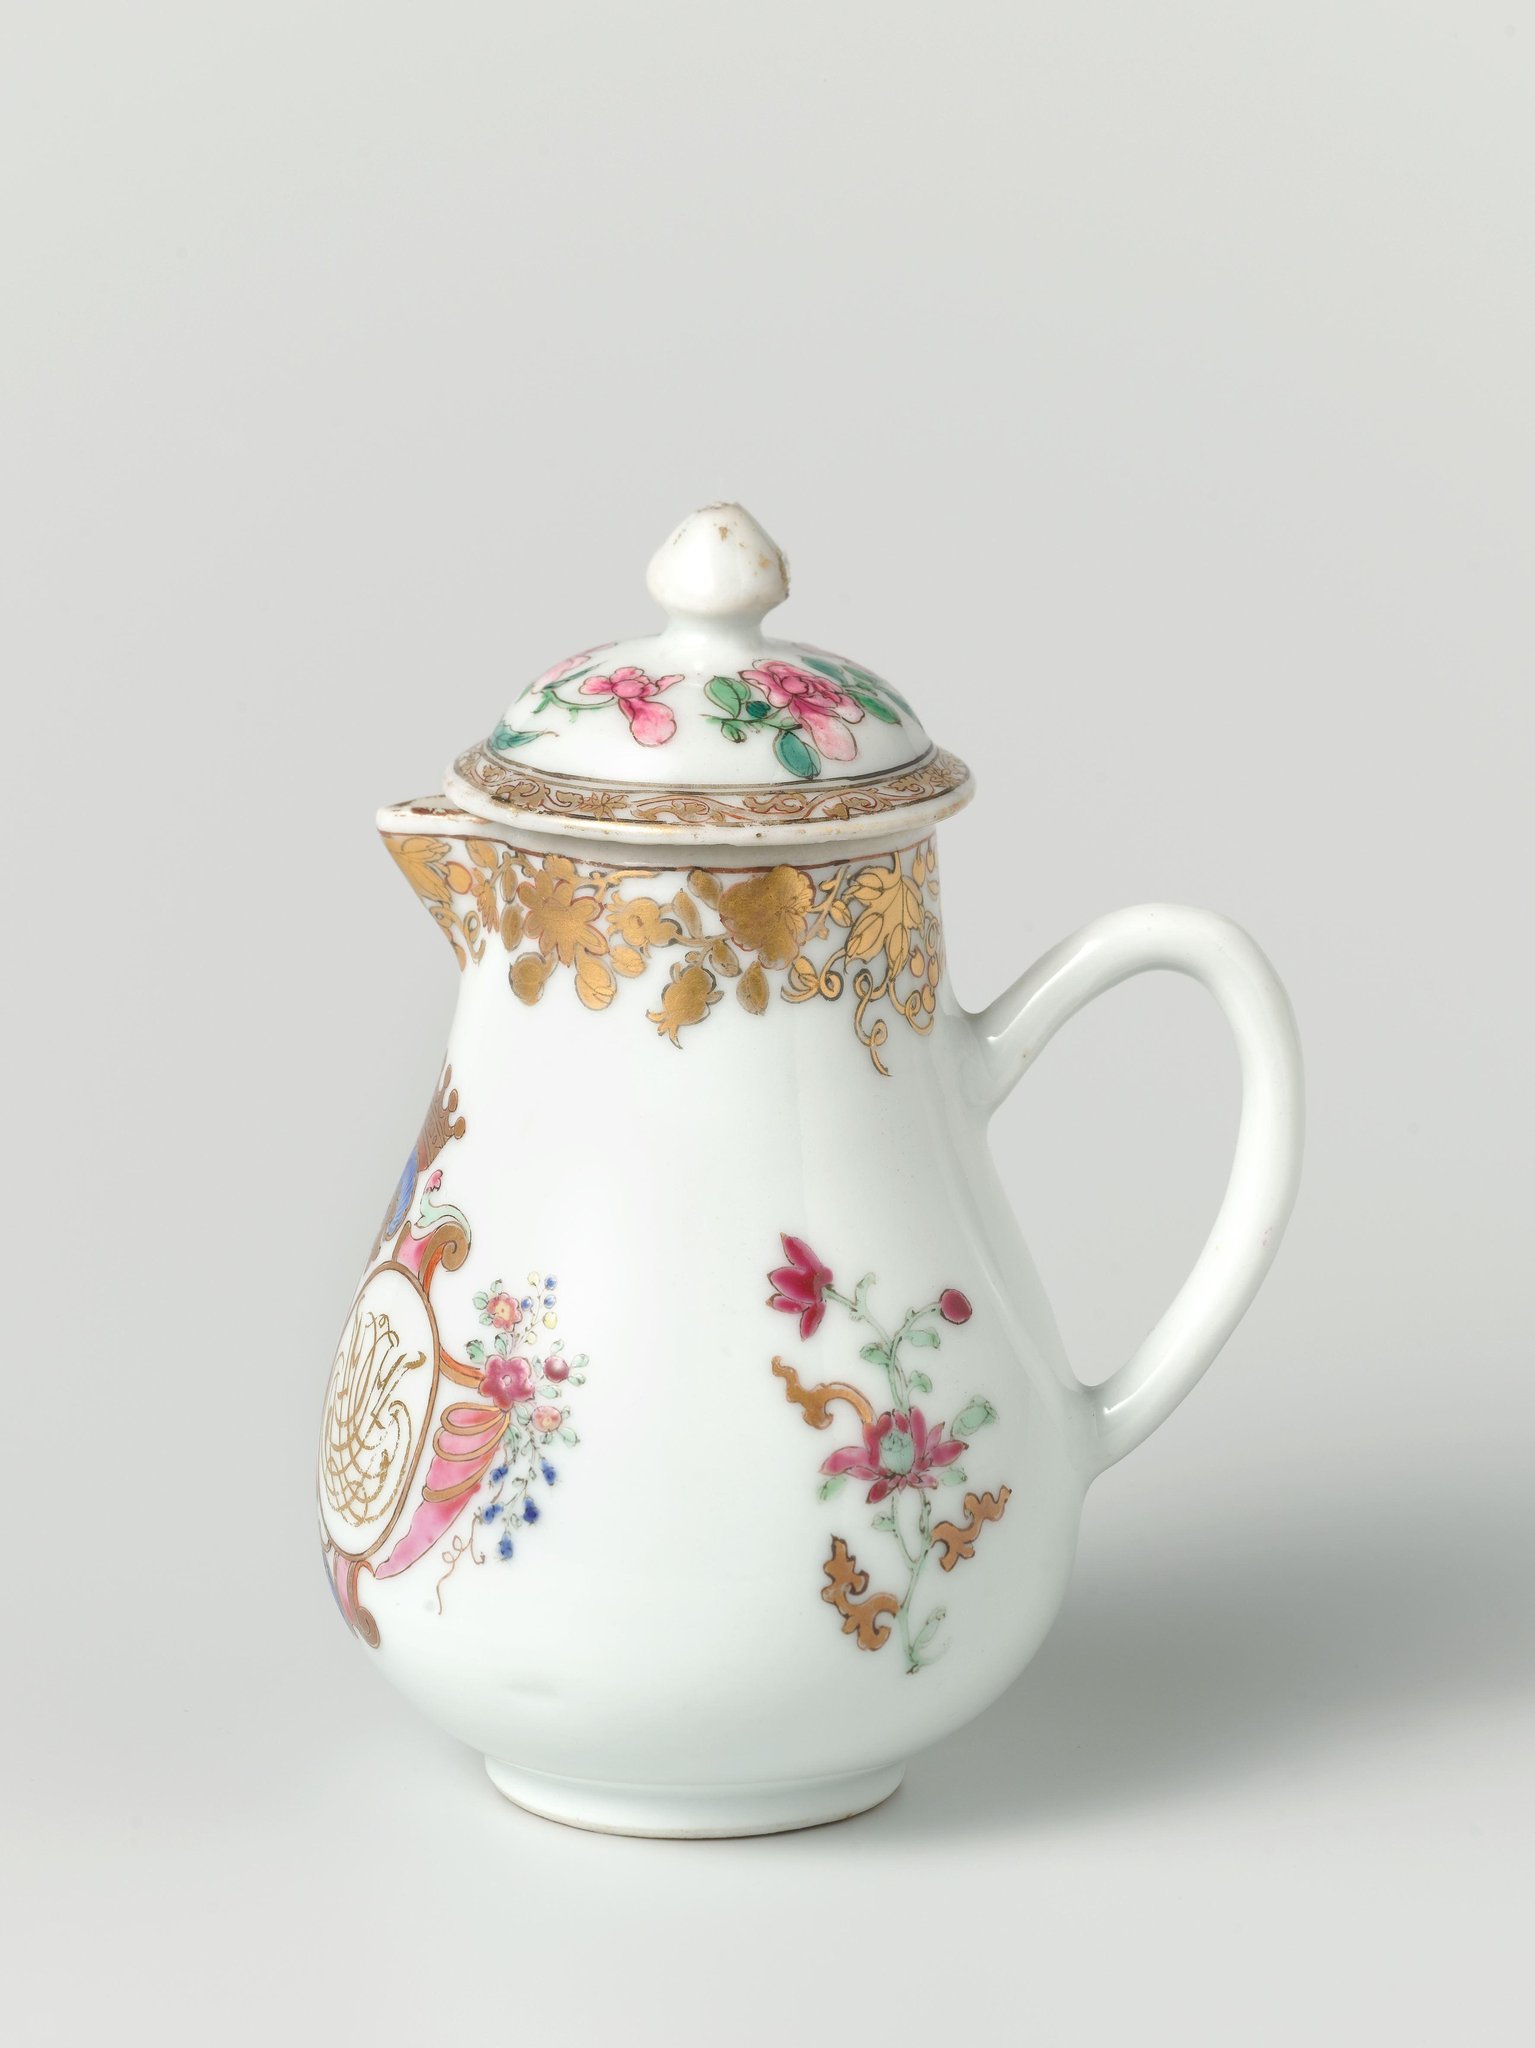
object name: milk jug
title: Pear-shaped milk jug with handle from the 'Swellengrebel service' with a double crowned monogram and a border with floral scrolls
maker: Anonymous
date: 1740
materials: glaze, gold, paint, porcelain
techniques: firing, gilding, turning, vitrification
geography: china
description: Peervormige melkkan van porselein met c-vormig oor en driehoekige tuit, beschilderd op het glazuur in blauw, rood, roze, groen, geel, zwart en goud. Op de buik een gekroond, dubbel spiegelmonogram met 'MVA' en 'CHTD' omgeven door schelpmotieven, krulwerk en bloemtakken; aan weerszijden van het wapen een lotusrank. Op de buitenrand met een band met bloemranken. Europese voorstelling in emailkleuren.